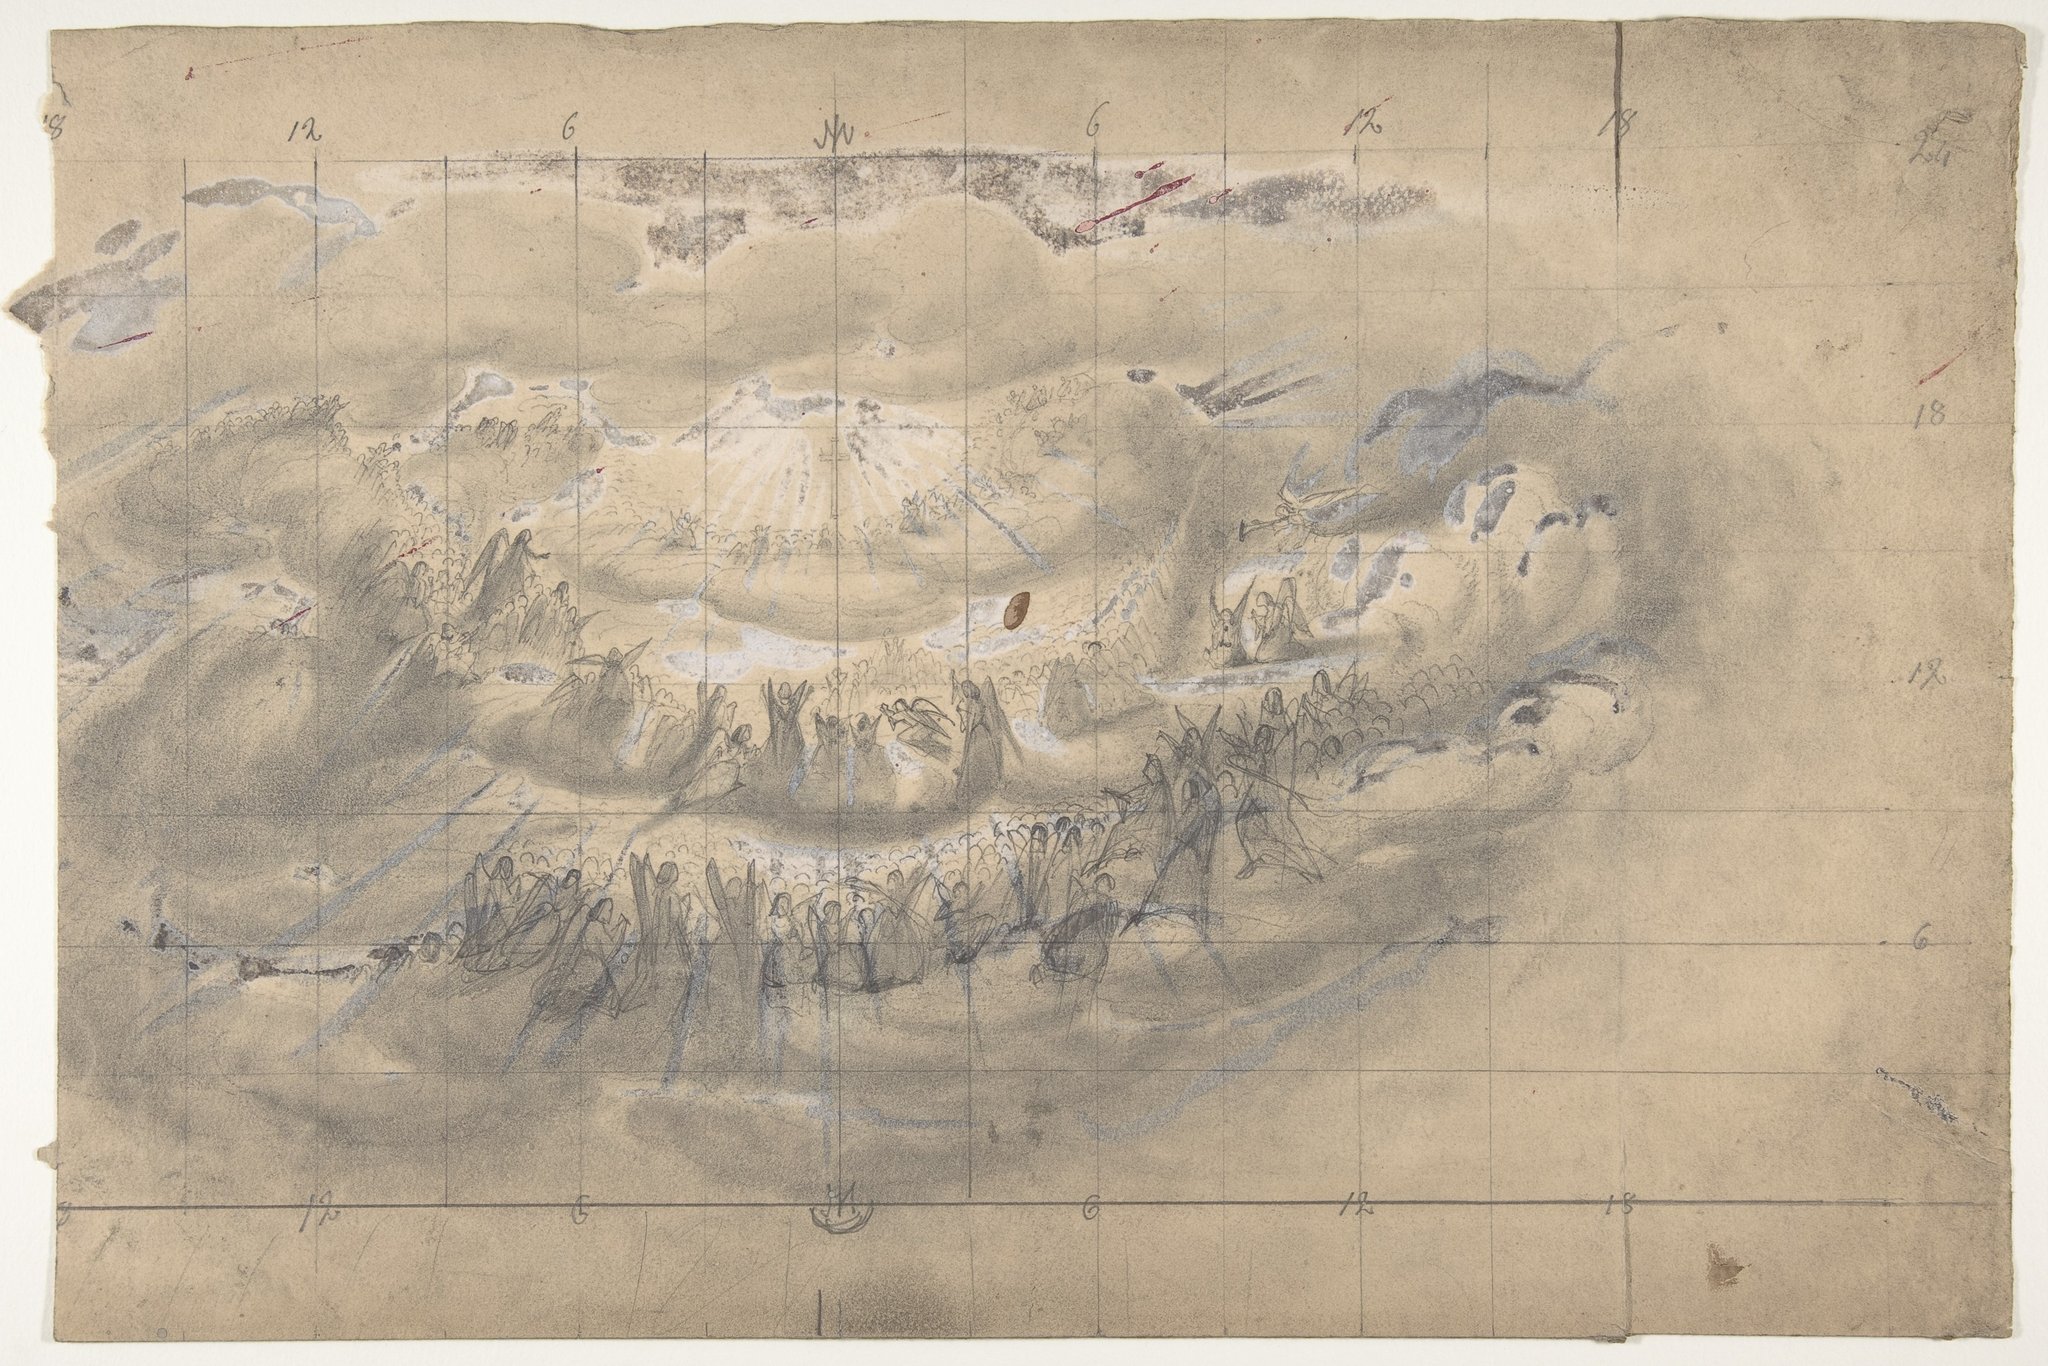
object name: drawing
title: Design for a Stage Set at the Opéra, Paris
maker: eugène cicéri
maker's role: artist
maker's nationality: french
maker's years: 1813-1890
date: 1828-1890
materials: chalk, graphite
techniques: heightening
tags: stage design